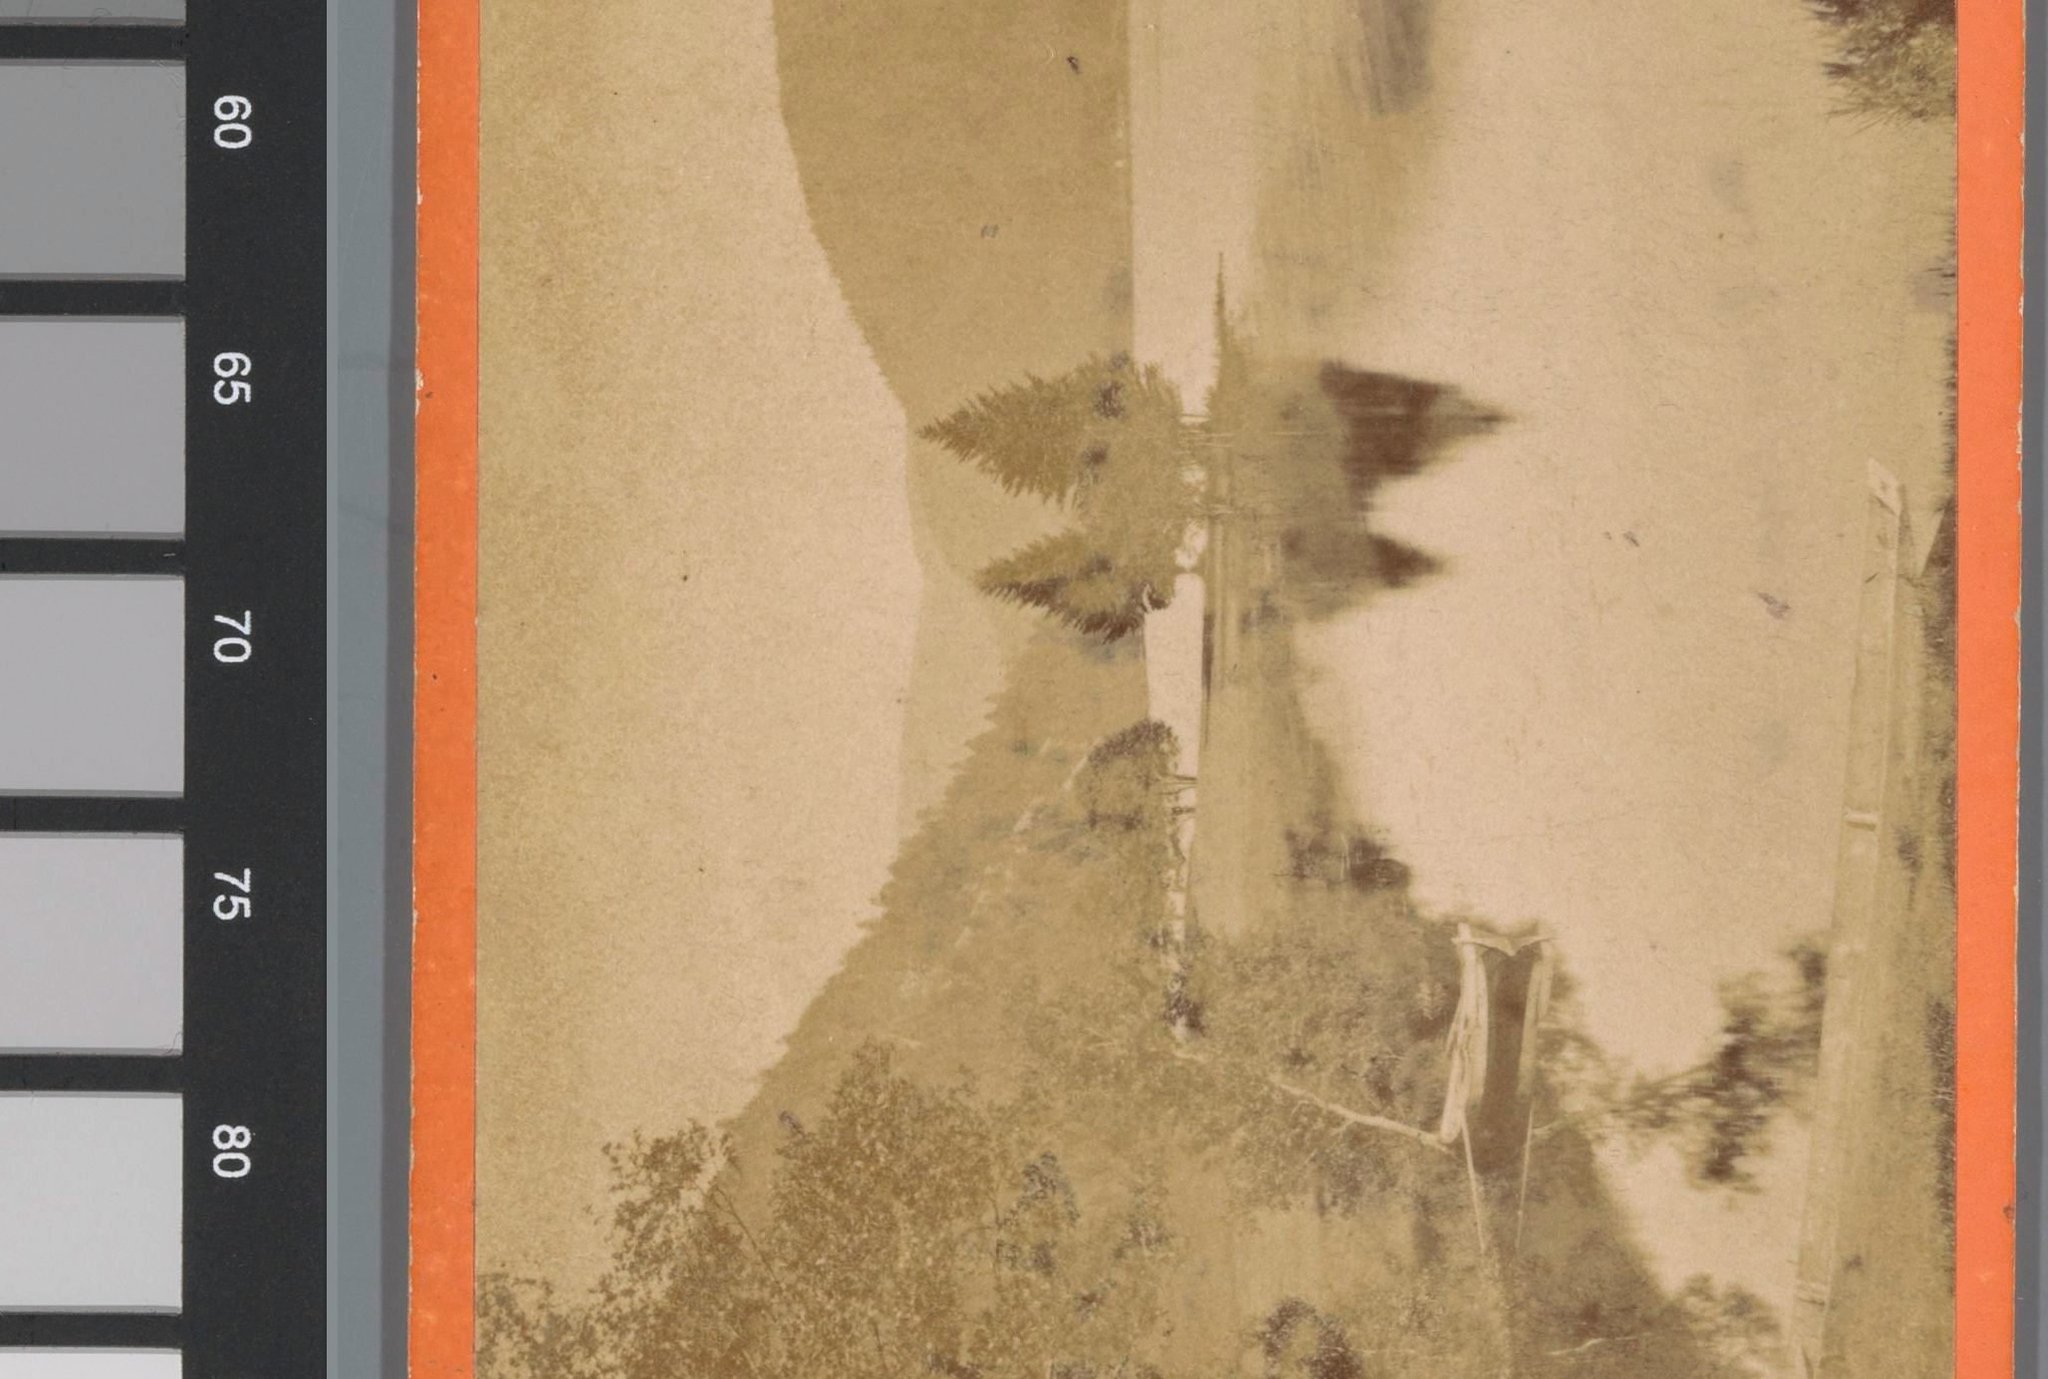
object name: photograph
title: Meer van Longemer, nabij Gérardmer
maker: Anonymous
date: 1881-1900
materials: cardboard, paper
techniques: albumen print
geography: vosges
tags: lake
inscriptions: inscription: ‘Ad. Braun & Cie./ photographes/ a/ Dornach (Alsace)/ &/ Paris/ 3, Boulevard des Capucines, 3/ 43, Avenue de l'Opéra, 43.’